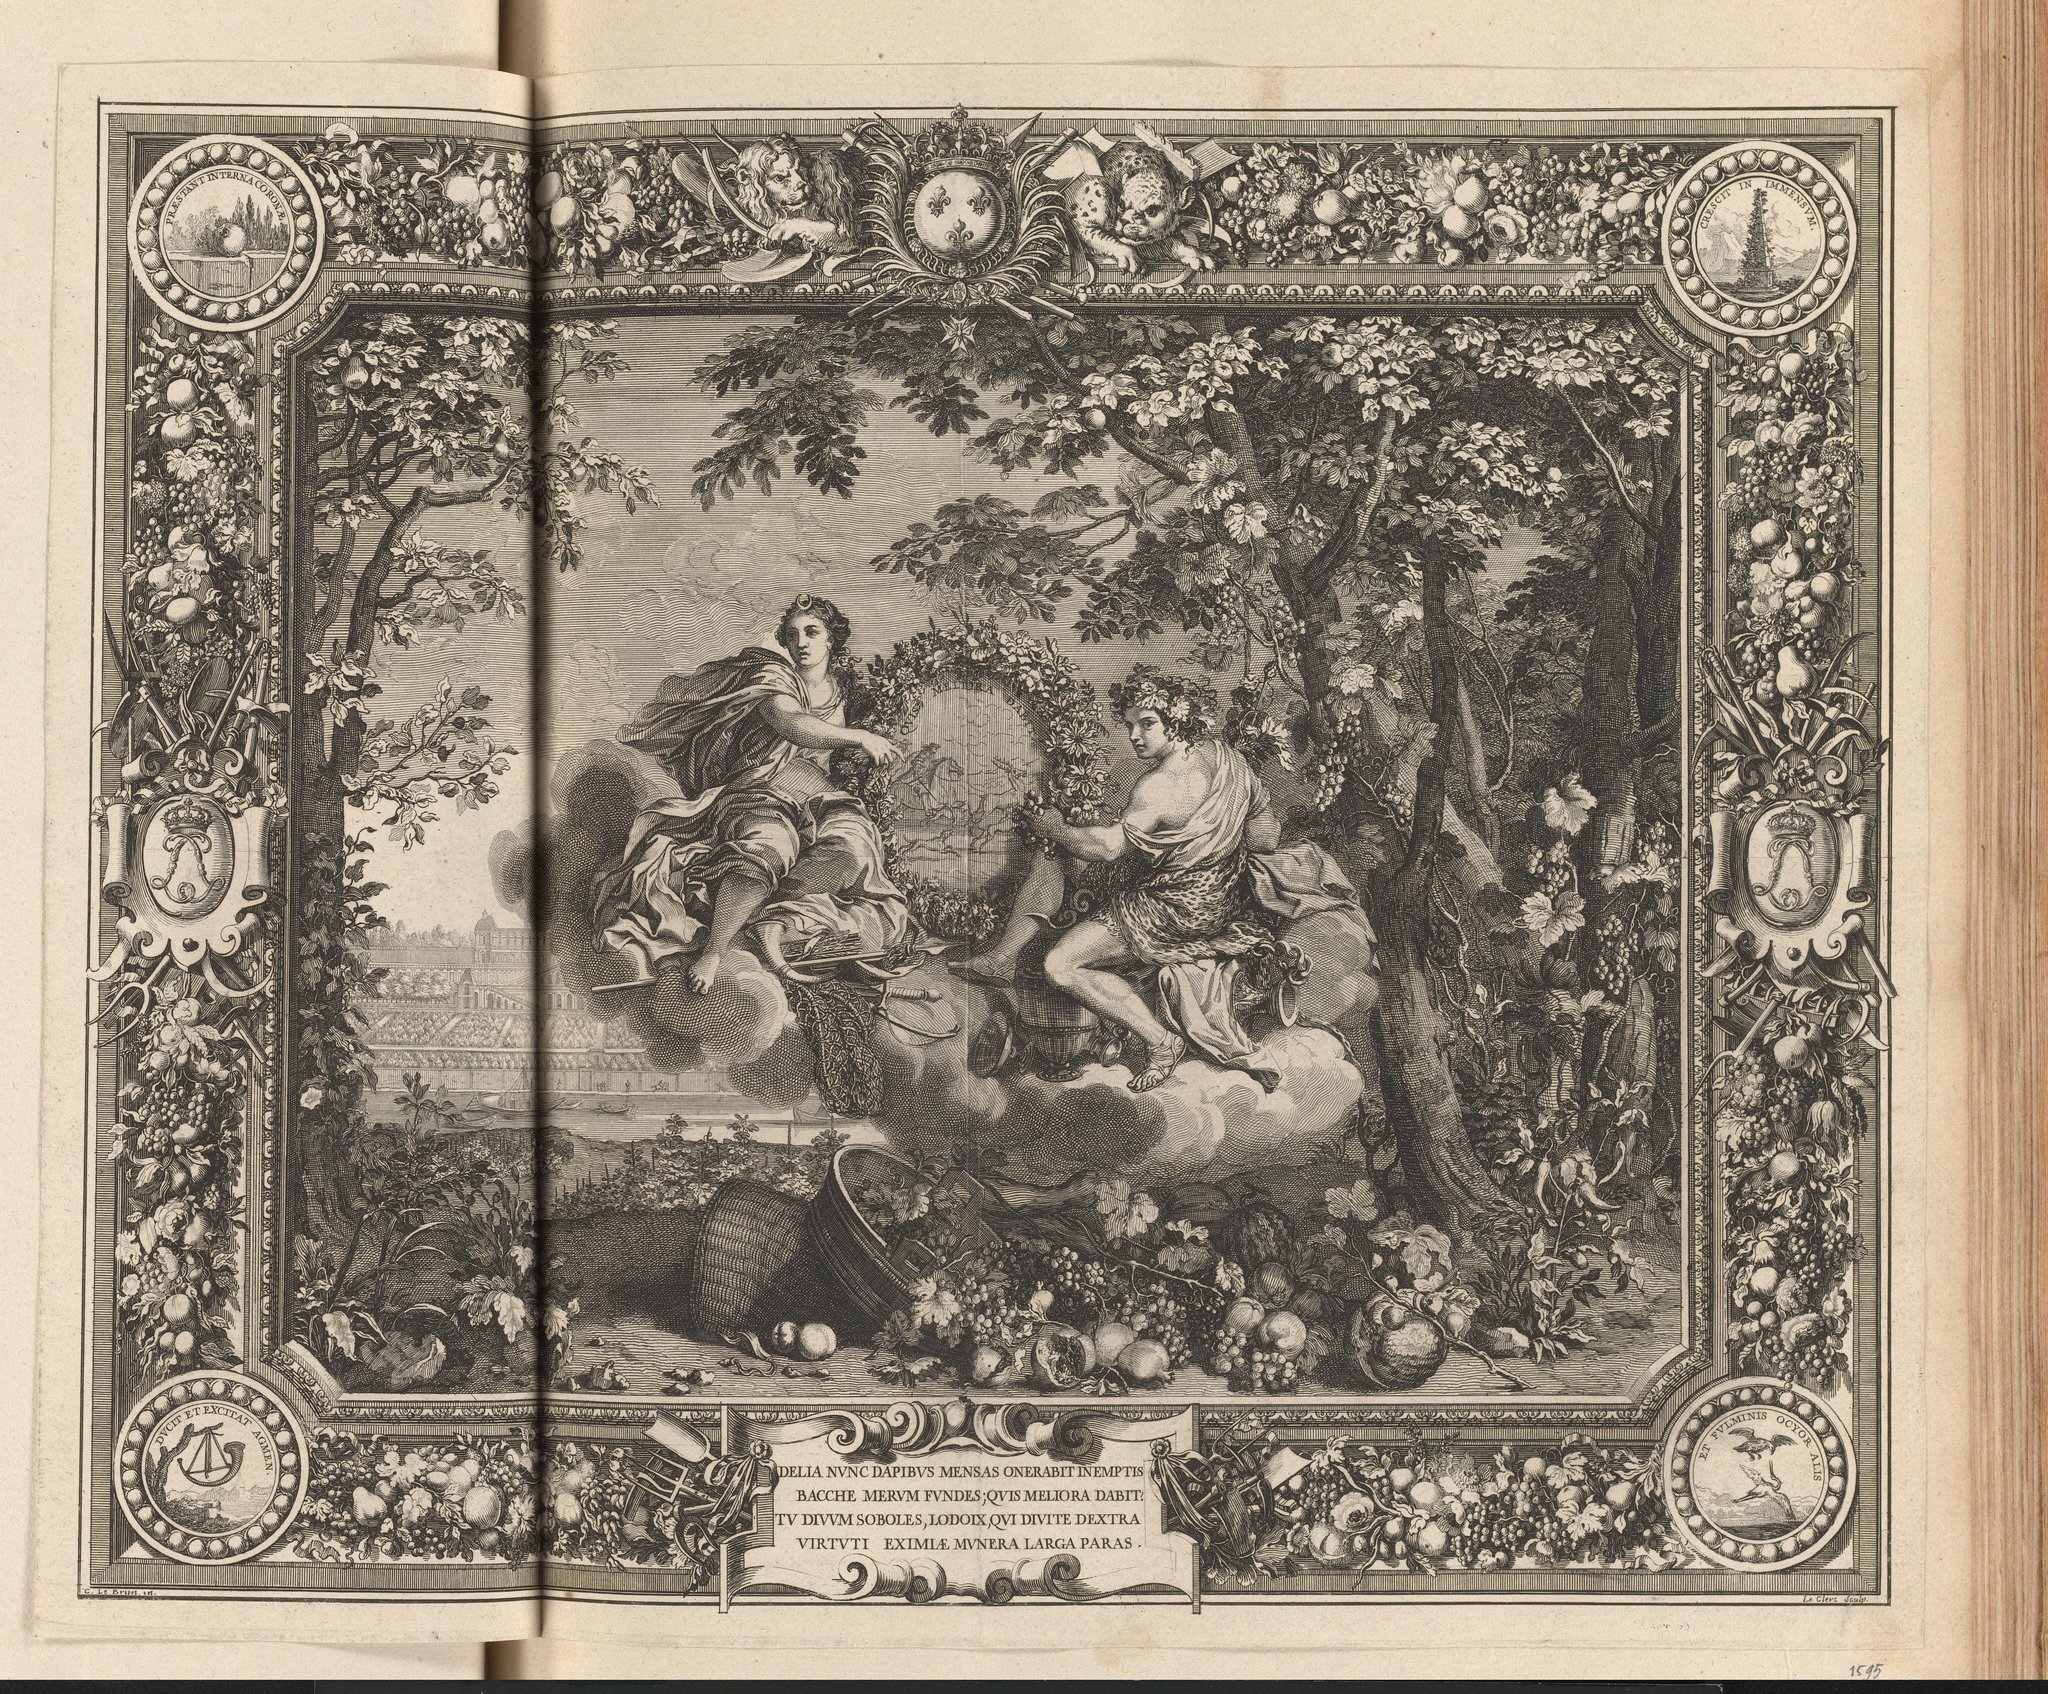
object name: book illustration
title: Allegorie op de herfst, in een cartouche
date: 1670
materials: paper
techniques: engraving, etching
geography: paris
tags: lodewijk xiv (koning van frankrijk), (story of) diana (artemis), earth (one of the four elements), (story of) bacchus (dionysus), liber, stag-hunting, fruits, autumn, fall, 'autumnus'; 'autunno' (ripa), bunch of grapes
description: Bacchus en Diane op een wolk, met tussen hen in een medaillon met Lodewijk XIV op jacht. Op de achtergrond is het kasteel van Saint-Germain-en-Laye te zien. Als omlijsting een ornamentele cartouche met objecten gerelateerd aan het element aarde. Prent maakt deel uit van een album.